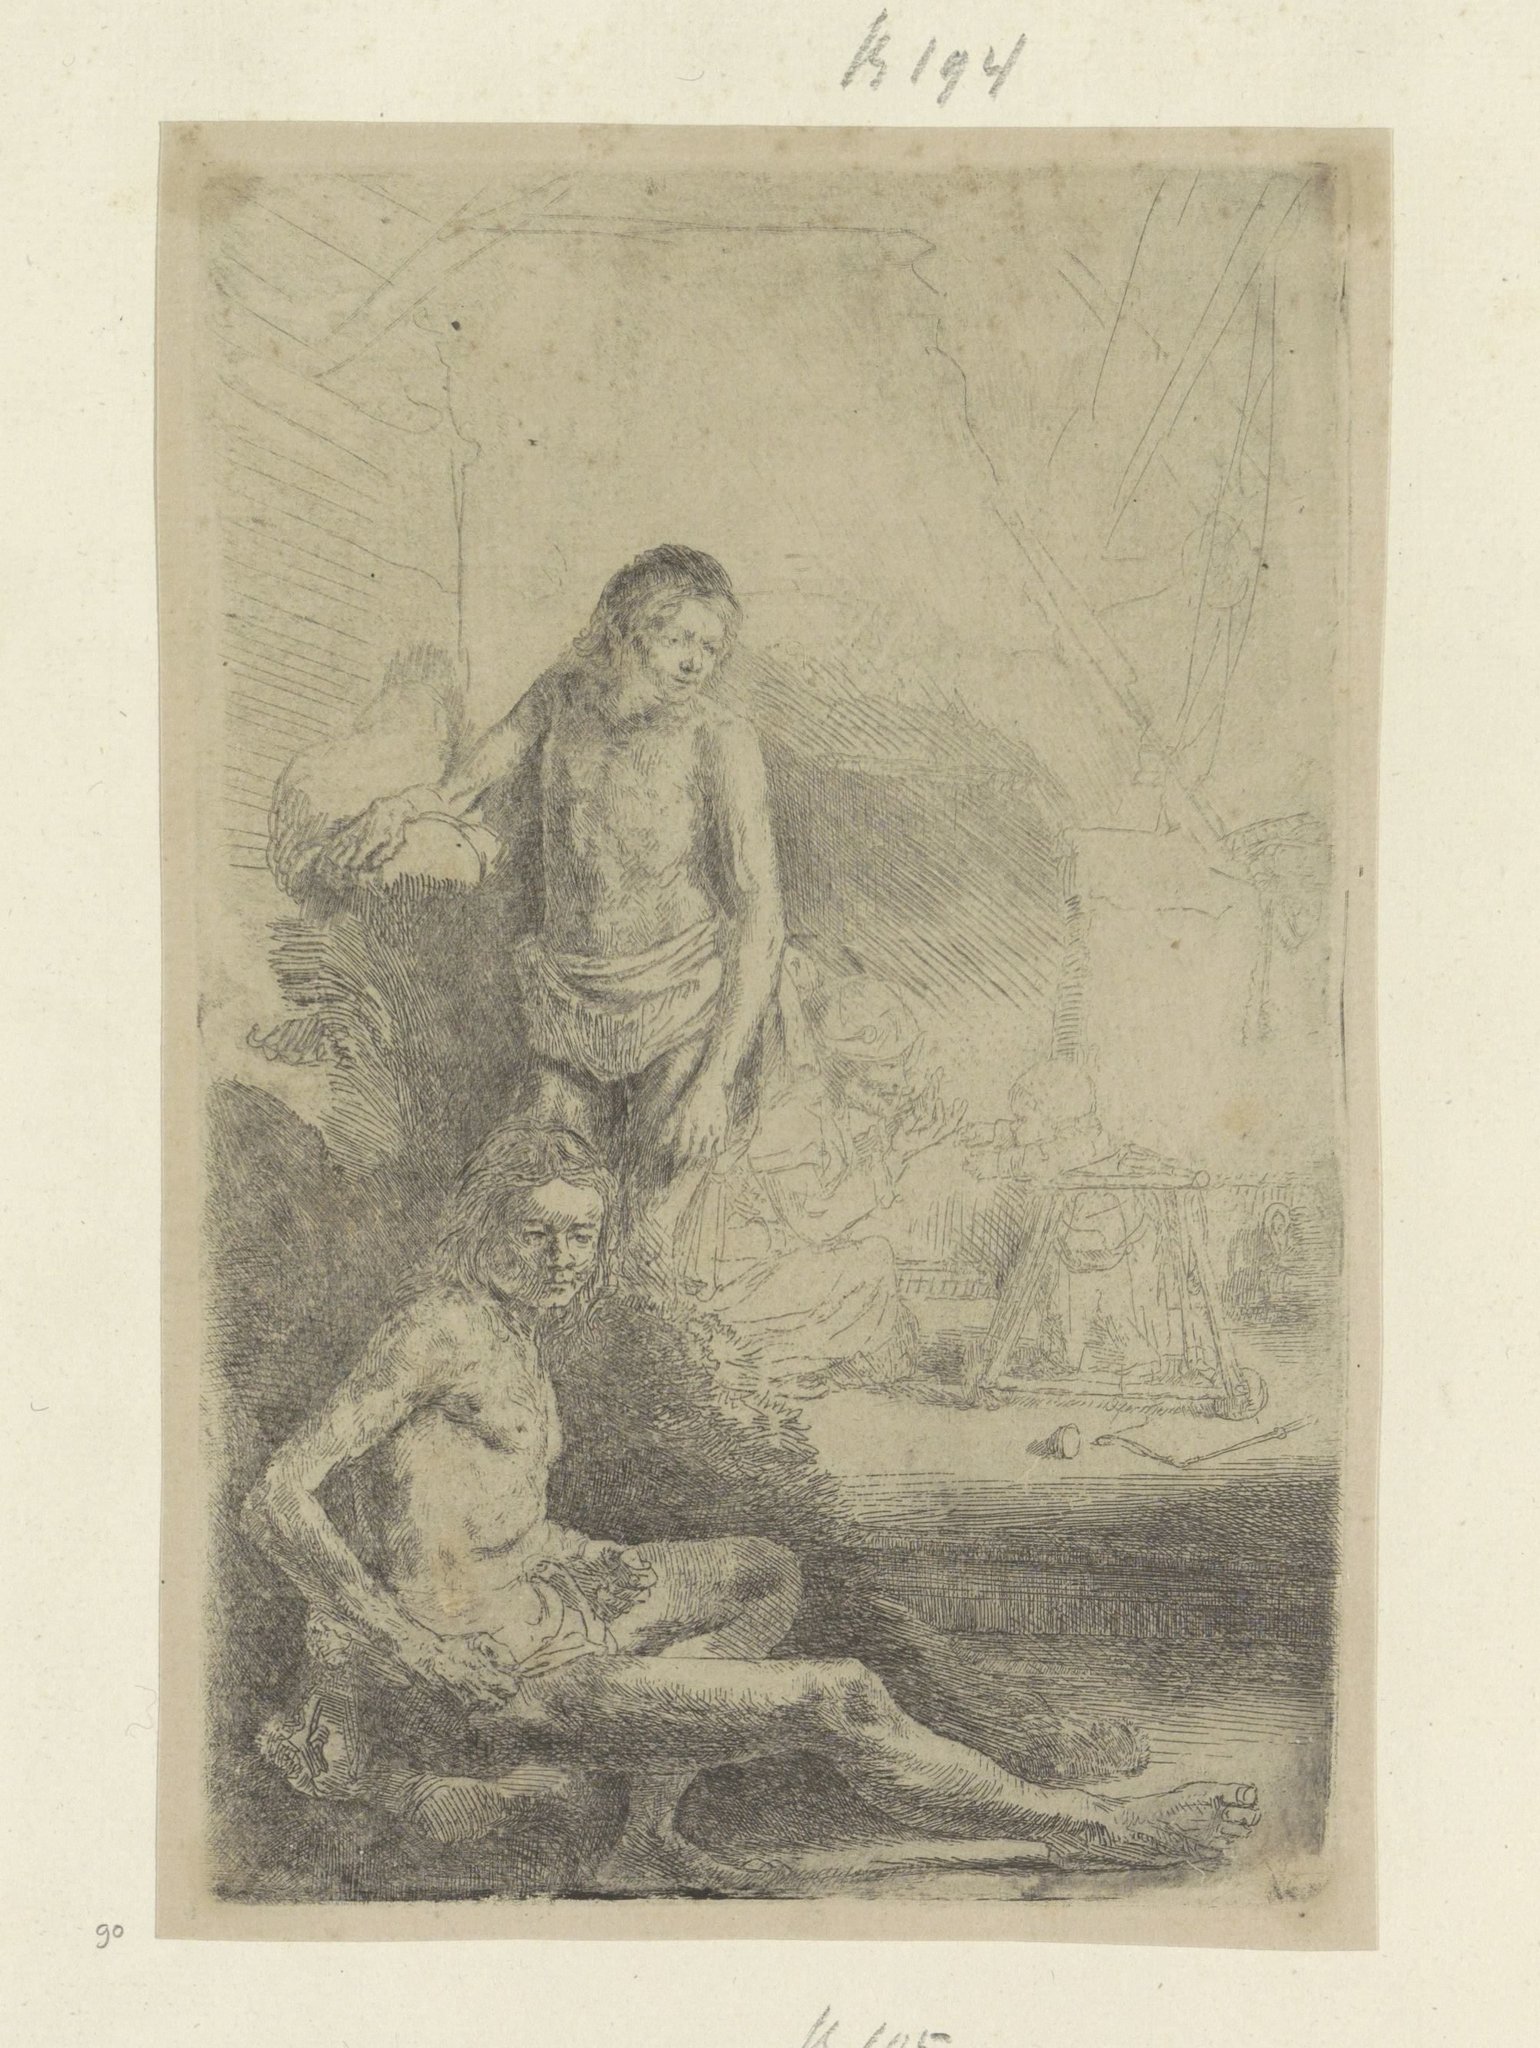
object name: print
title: Jongeman, zittend en staand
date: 1644-1648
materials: paper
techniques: etching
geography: paris